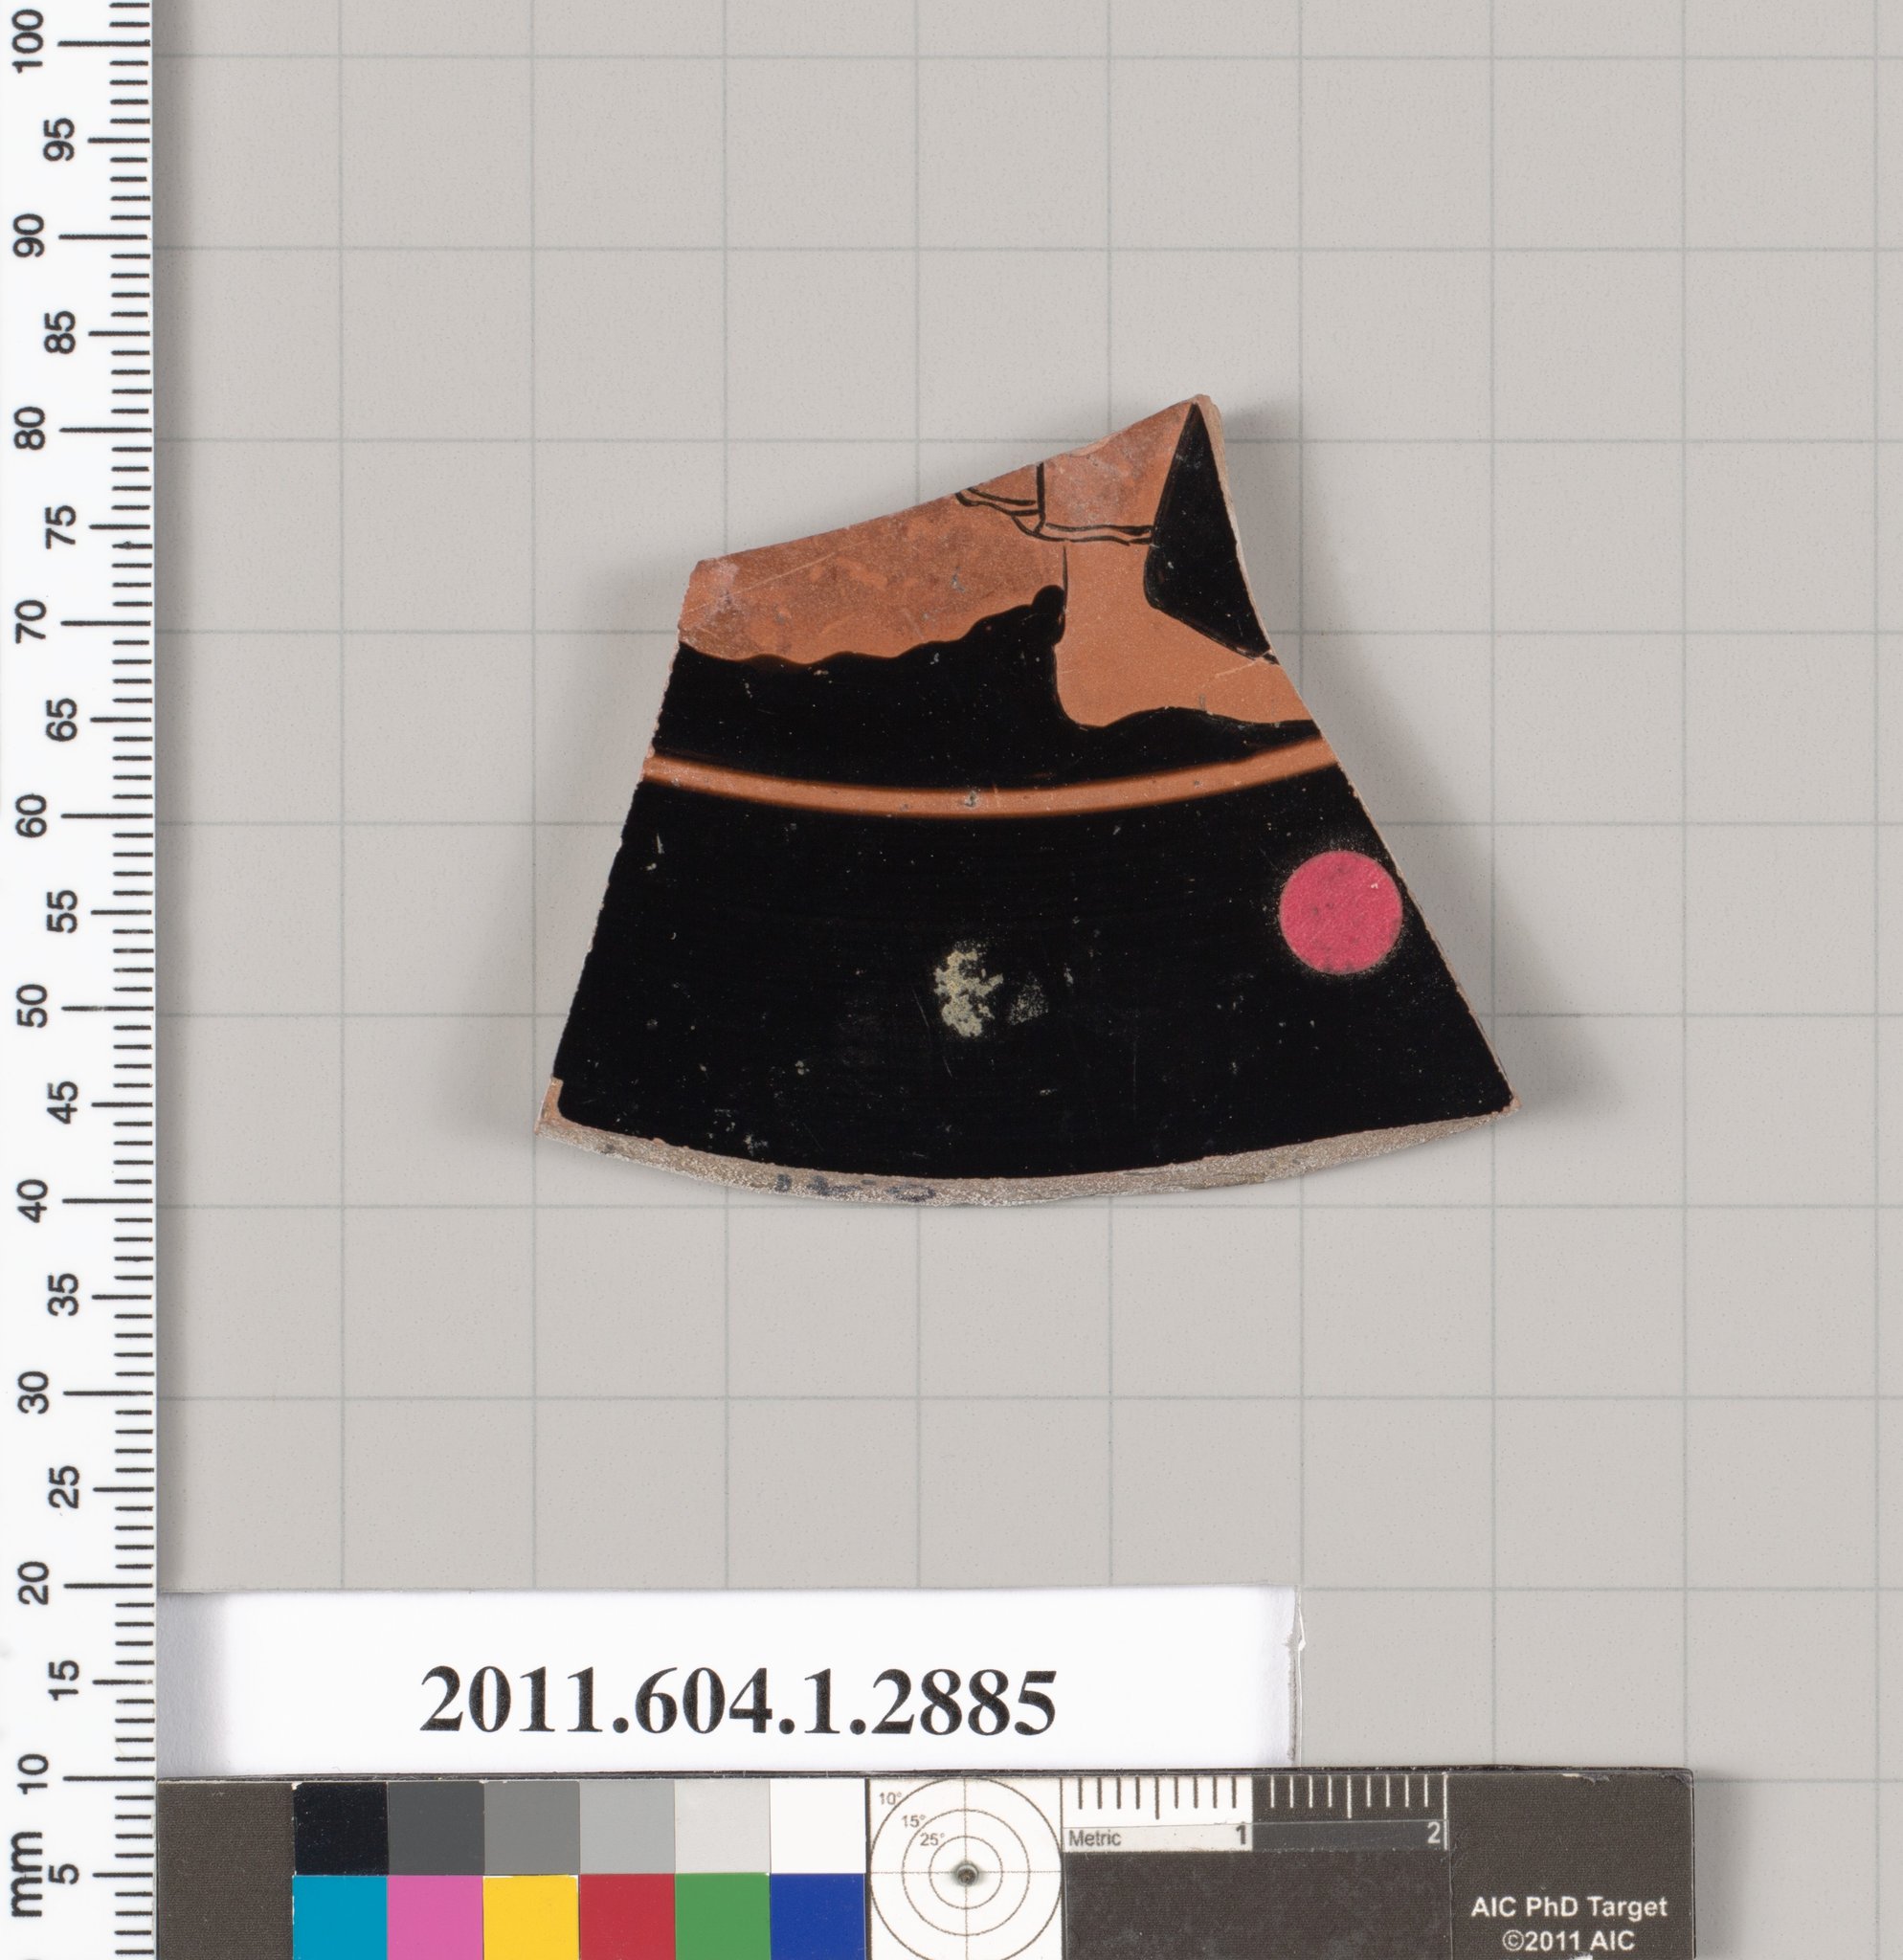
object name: kylix fragment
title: Terracotta fragment of a kylix (drinking cup)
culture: greek, attic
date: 490-480 BCE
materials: terracotta